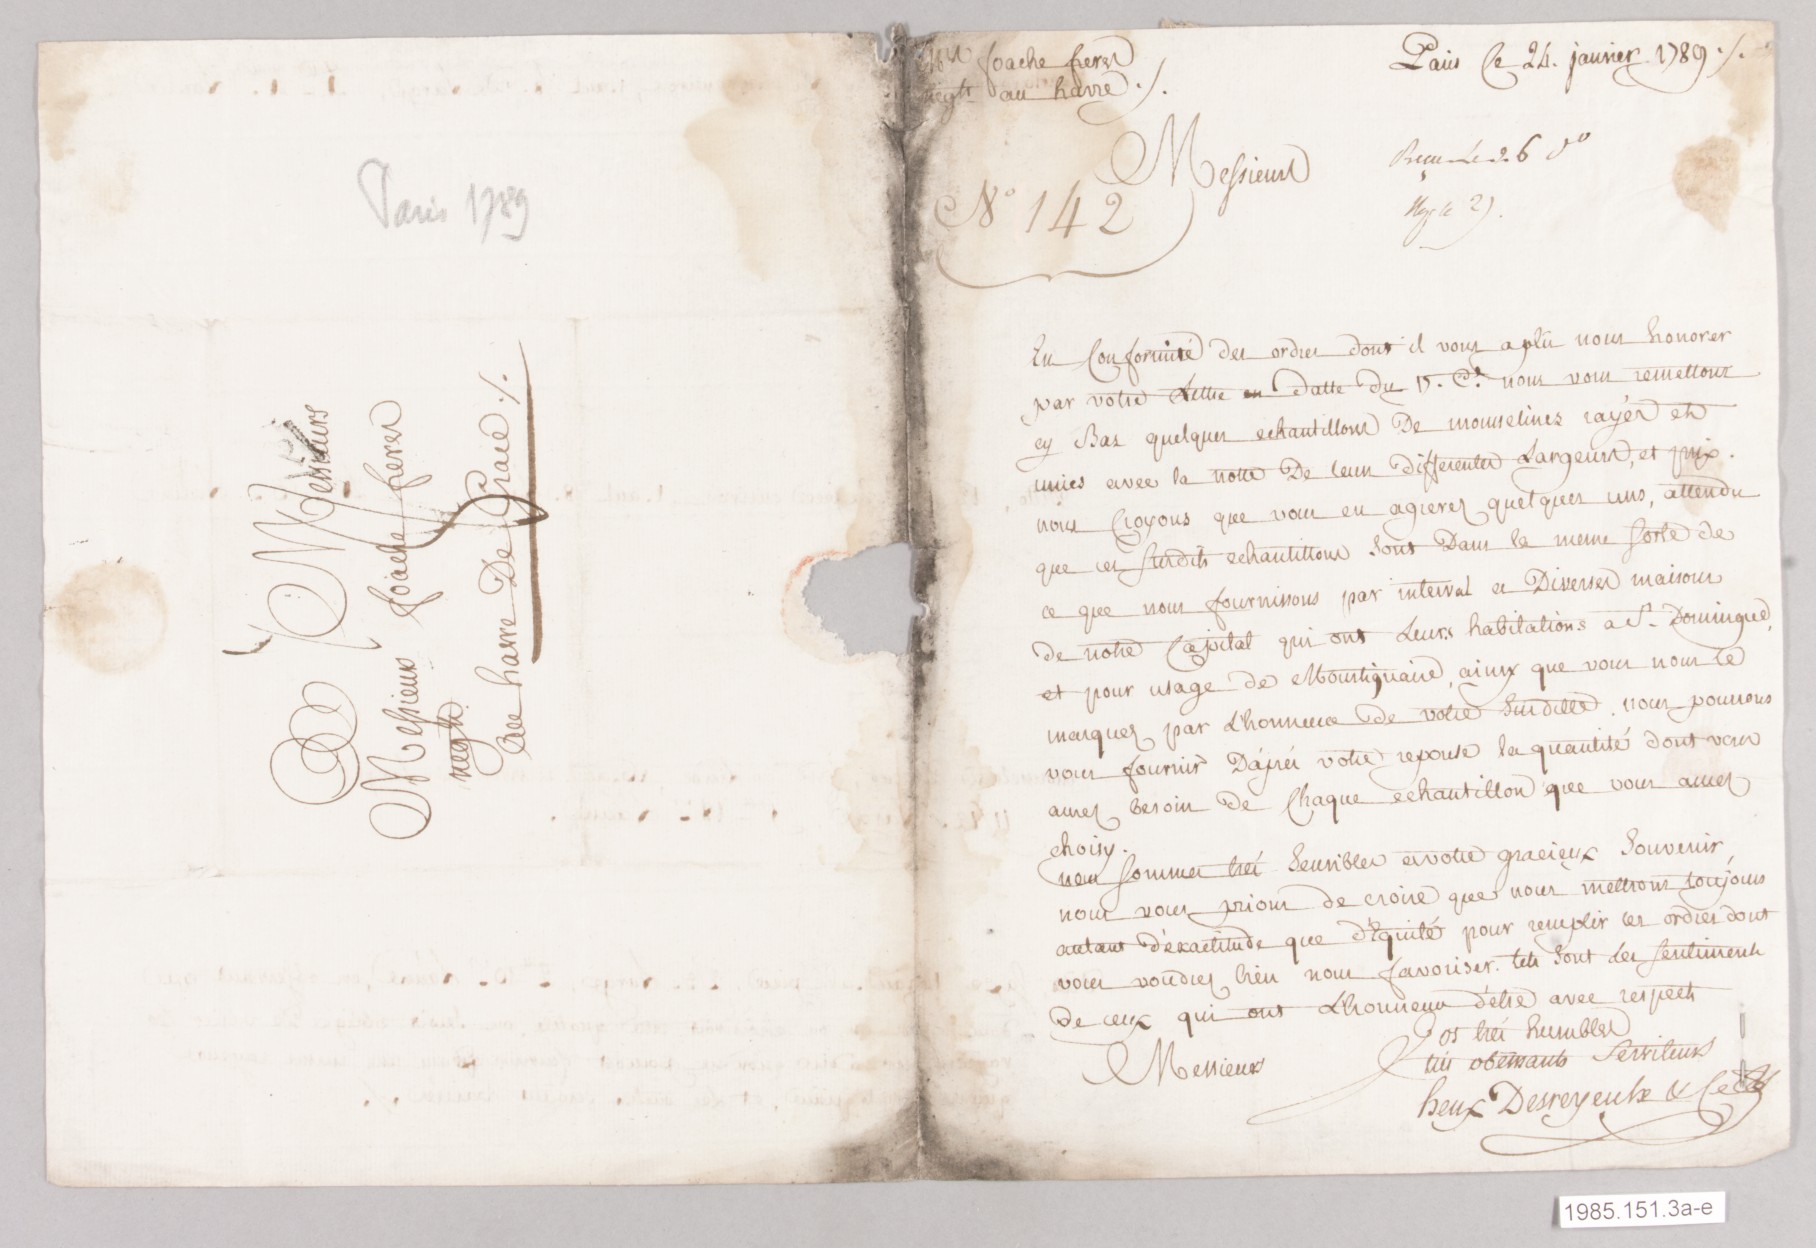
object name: sample and letter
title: Textile swatch to accompany letter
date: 1767-1800